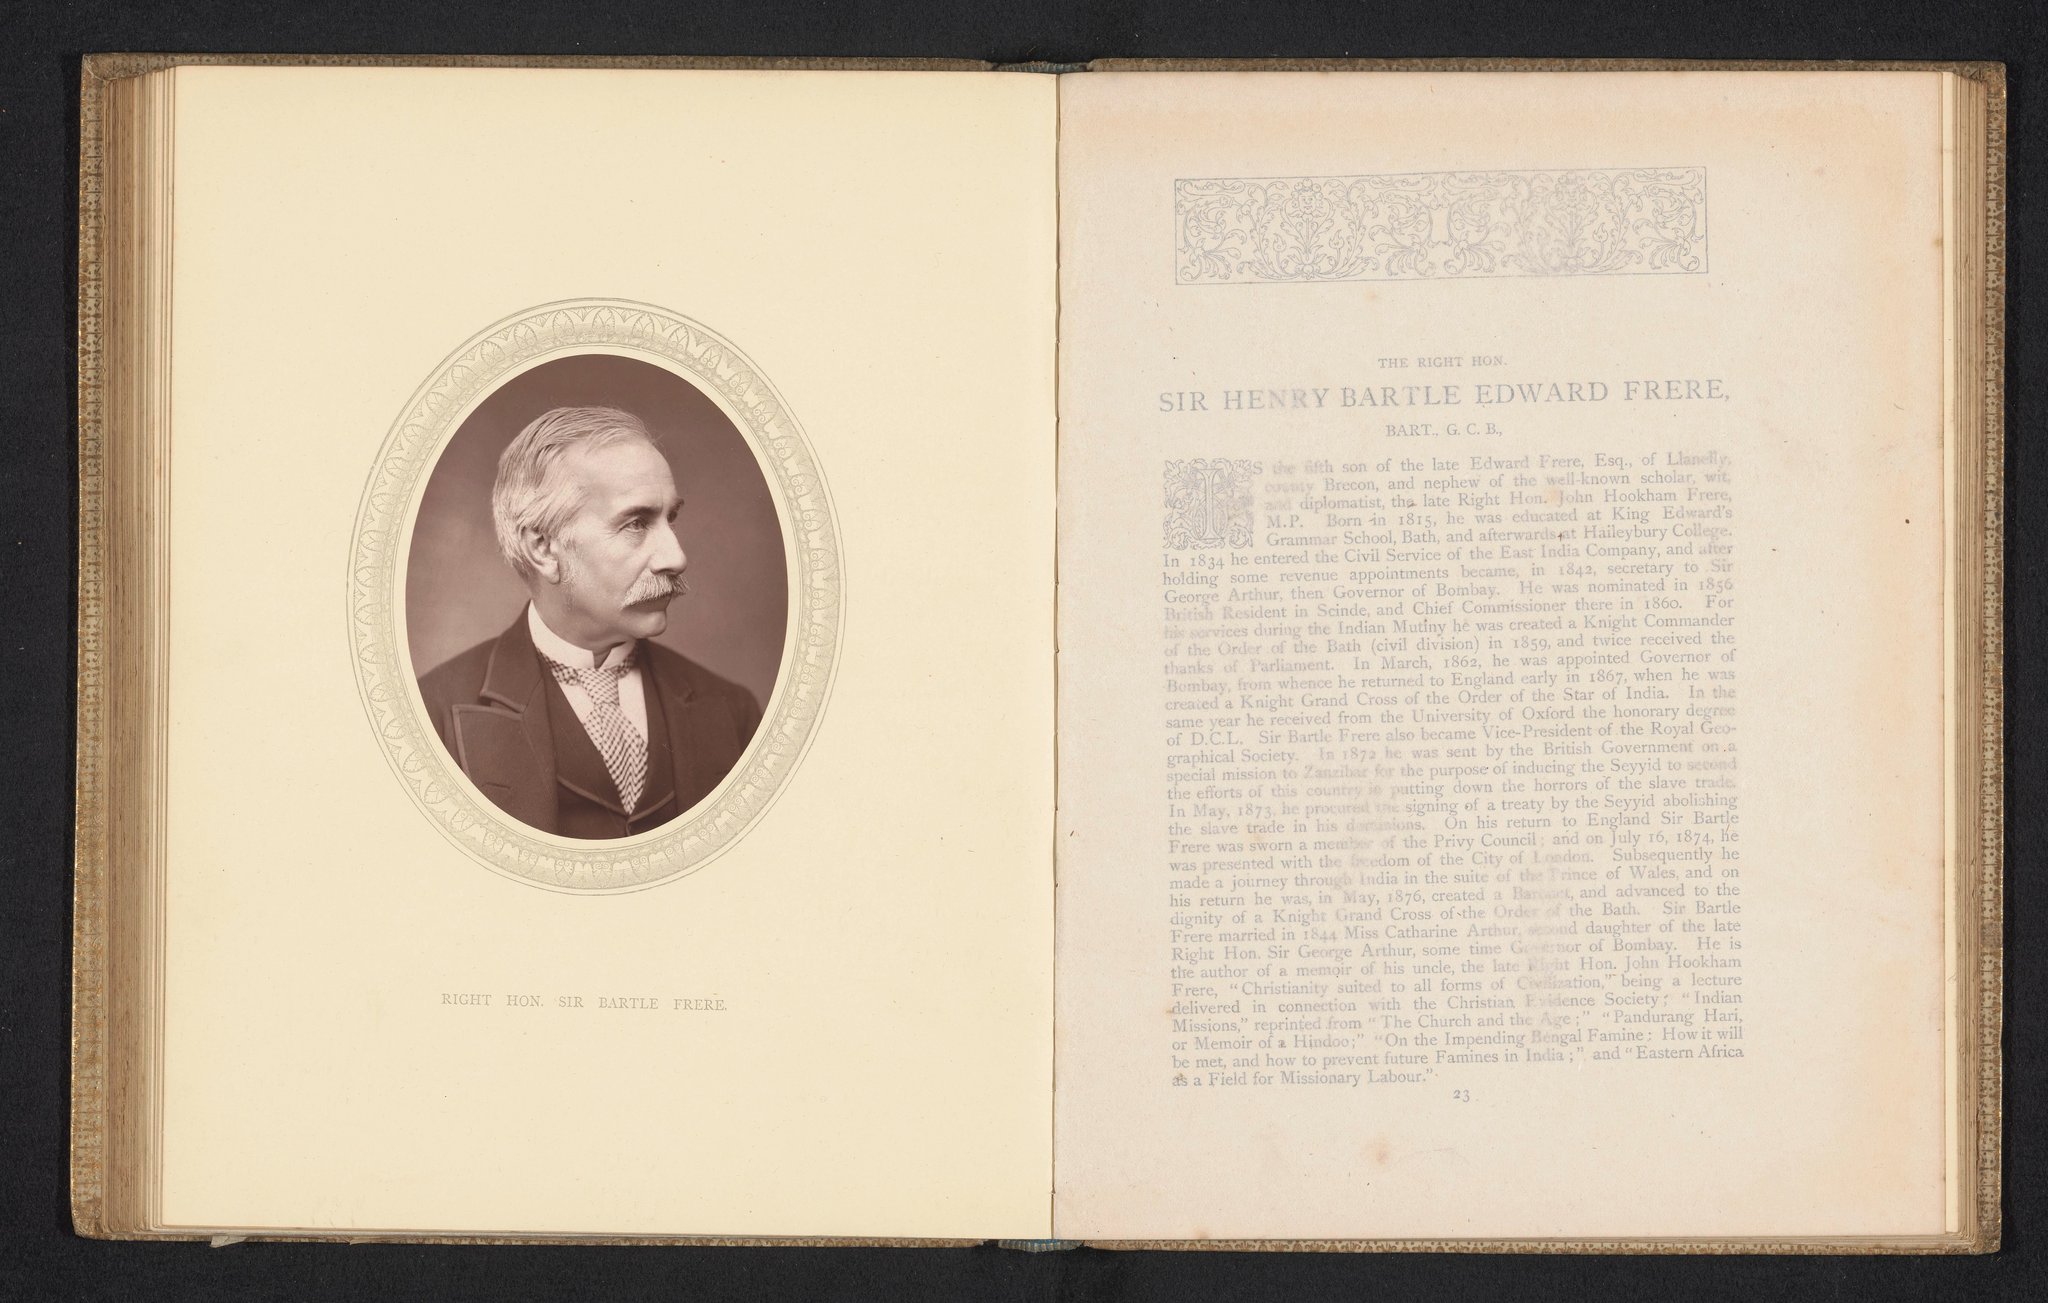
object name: photomechanical print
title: Right. hon. Sir Bartle Frere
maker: Anonymous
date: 1871-1876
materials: paper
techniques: woodburytype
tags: colonial governor, historical persons (portraits and scenes from the life) (+ (full) bust portrait)